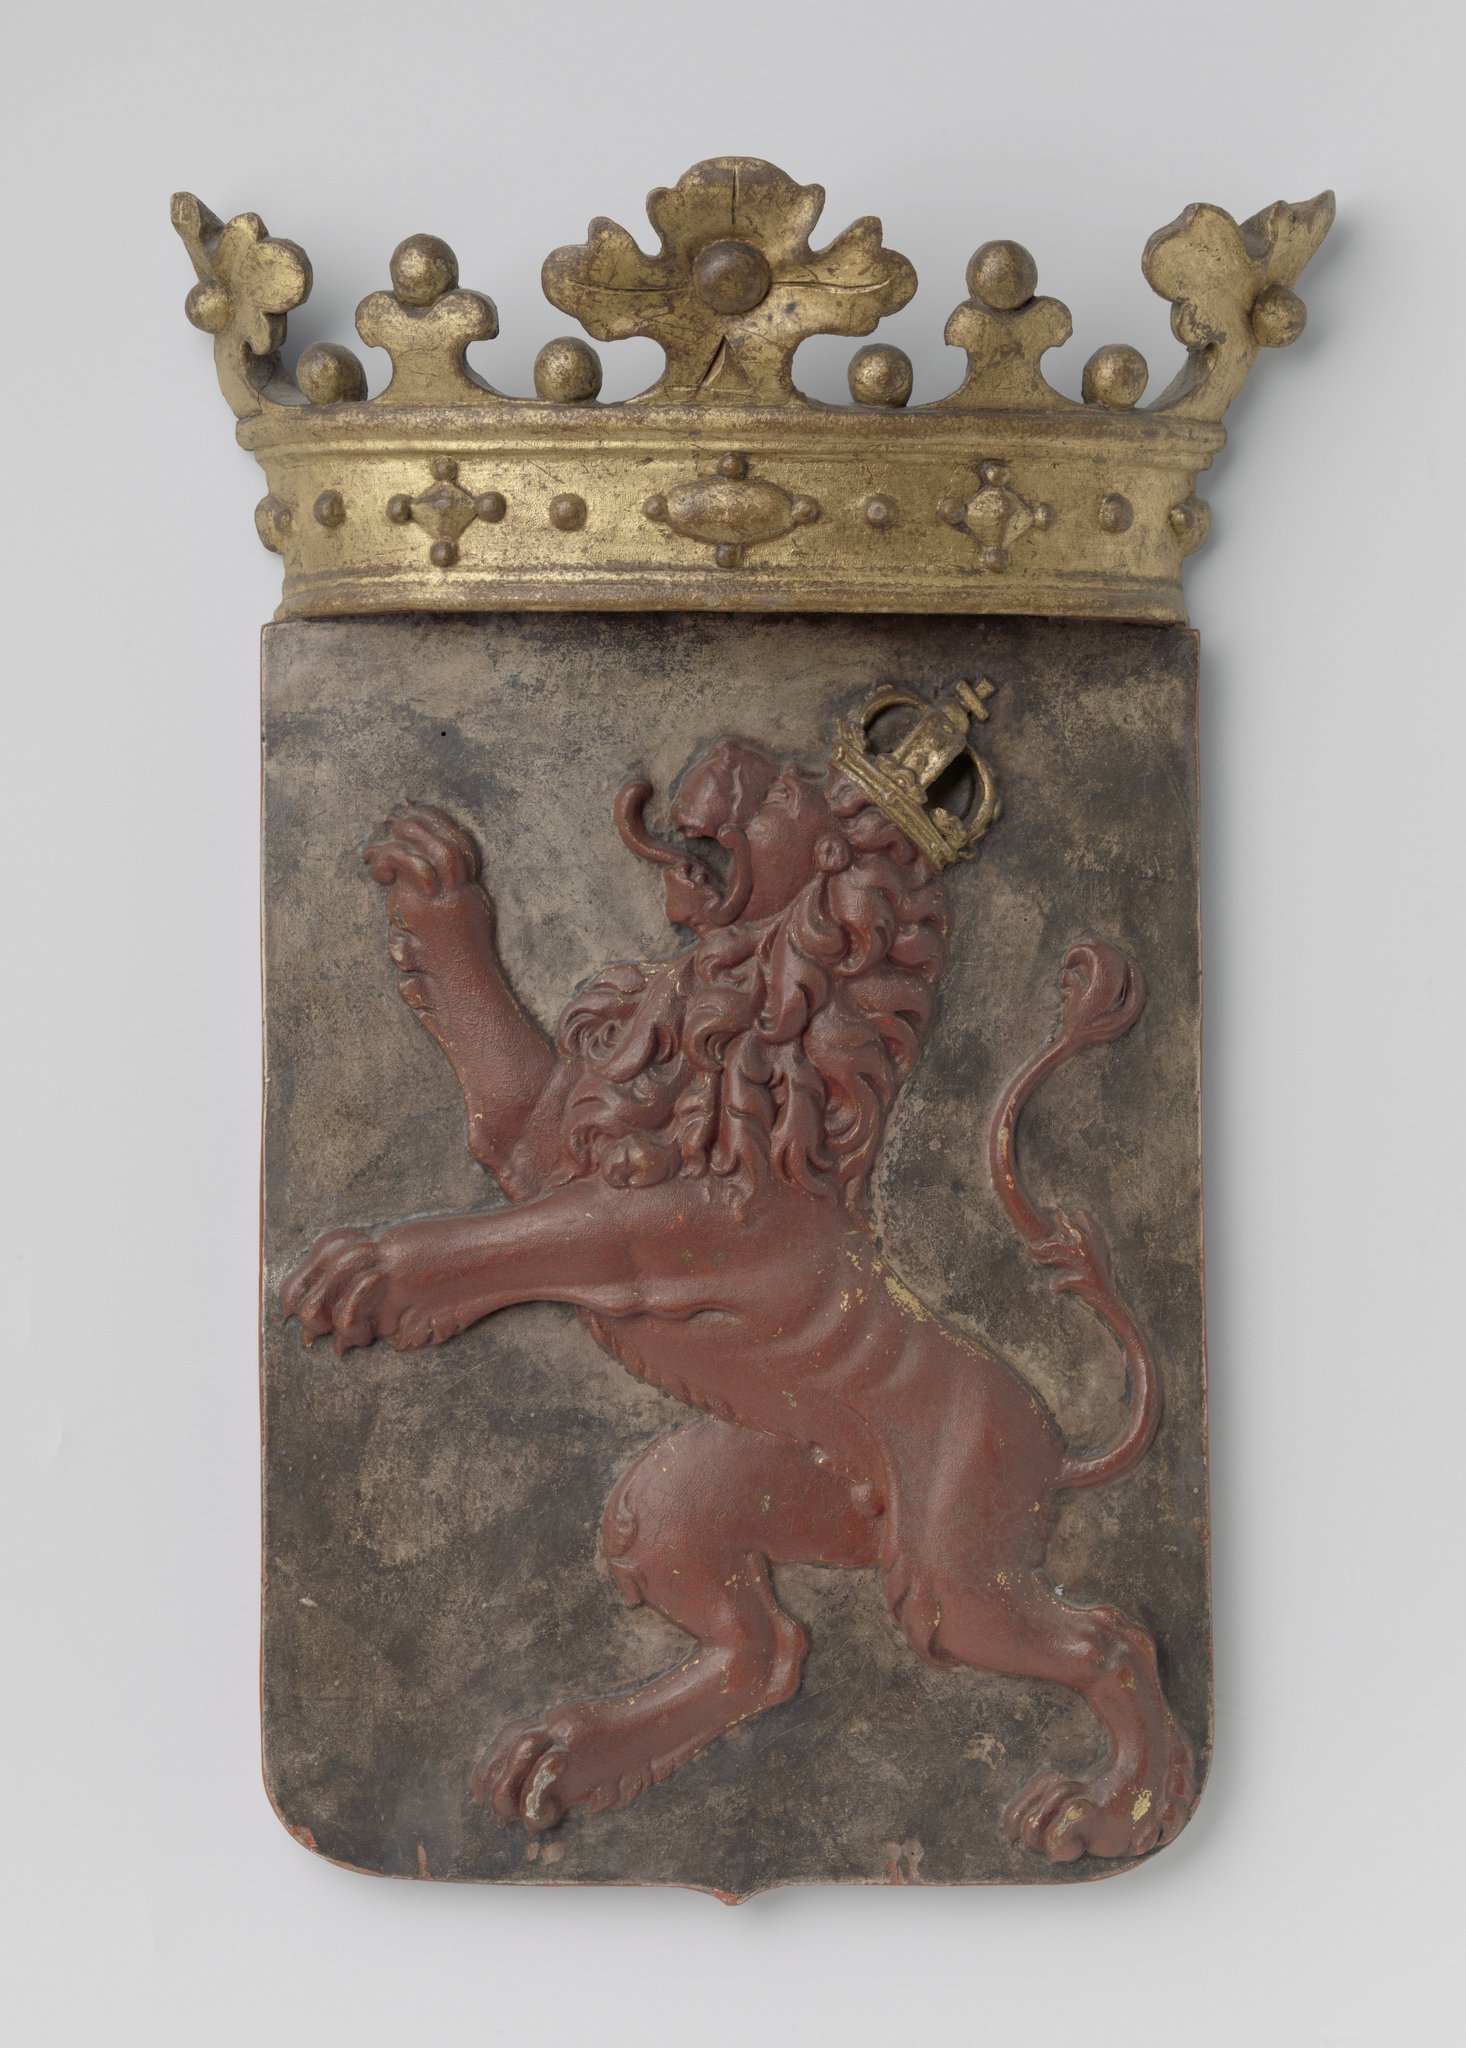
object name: wapenschild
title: Het hartschild van het wapen van Michiel Adriaenszoon de Ruyter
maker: Anonymous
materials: wood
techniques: polychromy, carving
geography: netherlands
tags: flushing, michiel adriaenszoon de ruyter, spain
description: Arms of the De Ruyter family, made between 1676 and 1683. Michiel de Ruyter was a commoner by birth. In gratitude for his exploits against the Swedes, the king of Denmark ennobled the Dutch admiral in 1660. De Ruyter received a coat of arms of which the four quarters represented the Danish flag, a ship at sea, a gun and a horseman - a play on his name. The Spanish king awarded De Ruyter's son Engel a baronetcy in 1678. This added a heart-shaped shield with a lion to the family coat of arms.